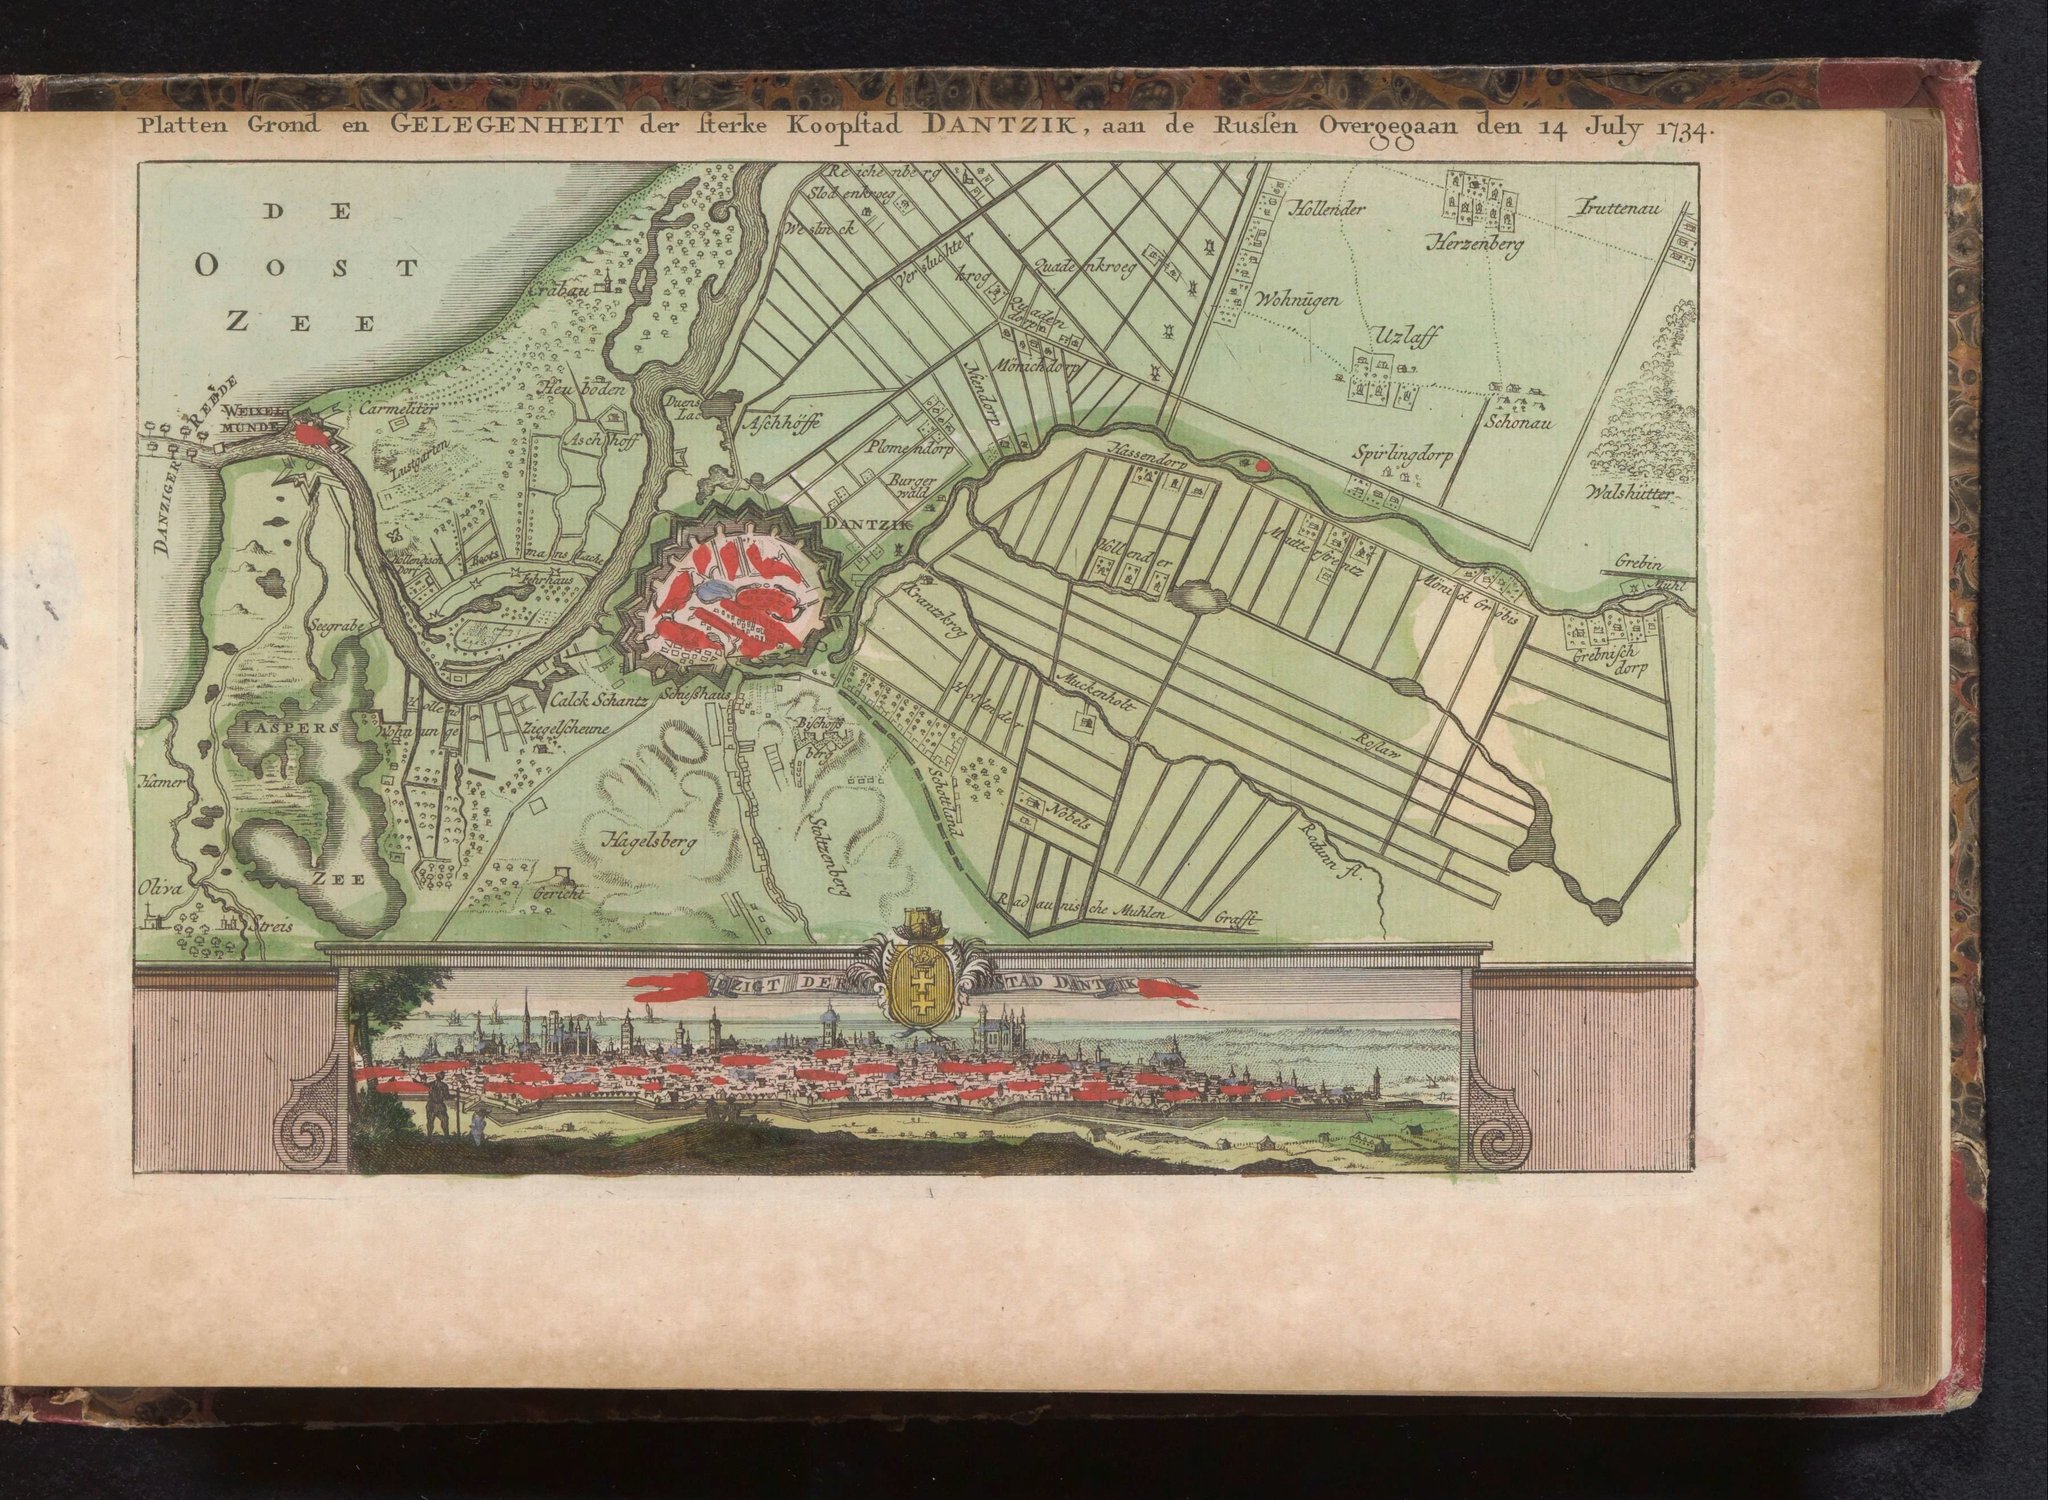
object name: print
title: Platten Grond en Gelegenheit der sterke Koopstad Dantzik, aan de Russen Overgegaan den 14 July 1734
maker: Anonymous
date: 1735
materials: paper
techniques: engraving, etching, hand coloring, lacquer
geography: amsterdam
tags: maps of cities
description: Kaart met een plattegrond van de Poolse stad Danzig, onderaan een gezicht op de stad. Na de verovering door de Russen op 14 juli 1734 tijdens de Poolse Successieoorlog. Onderdeel van een atlas met 223 kaarten van landen en steden en oorlogstaferelen in Europa in de periode ca. 1690-1735.